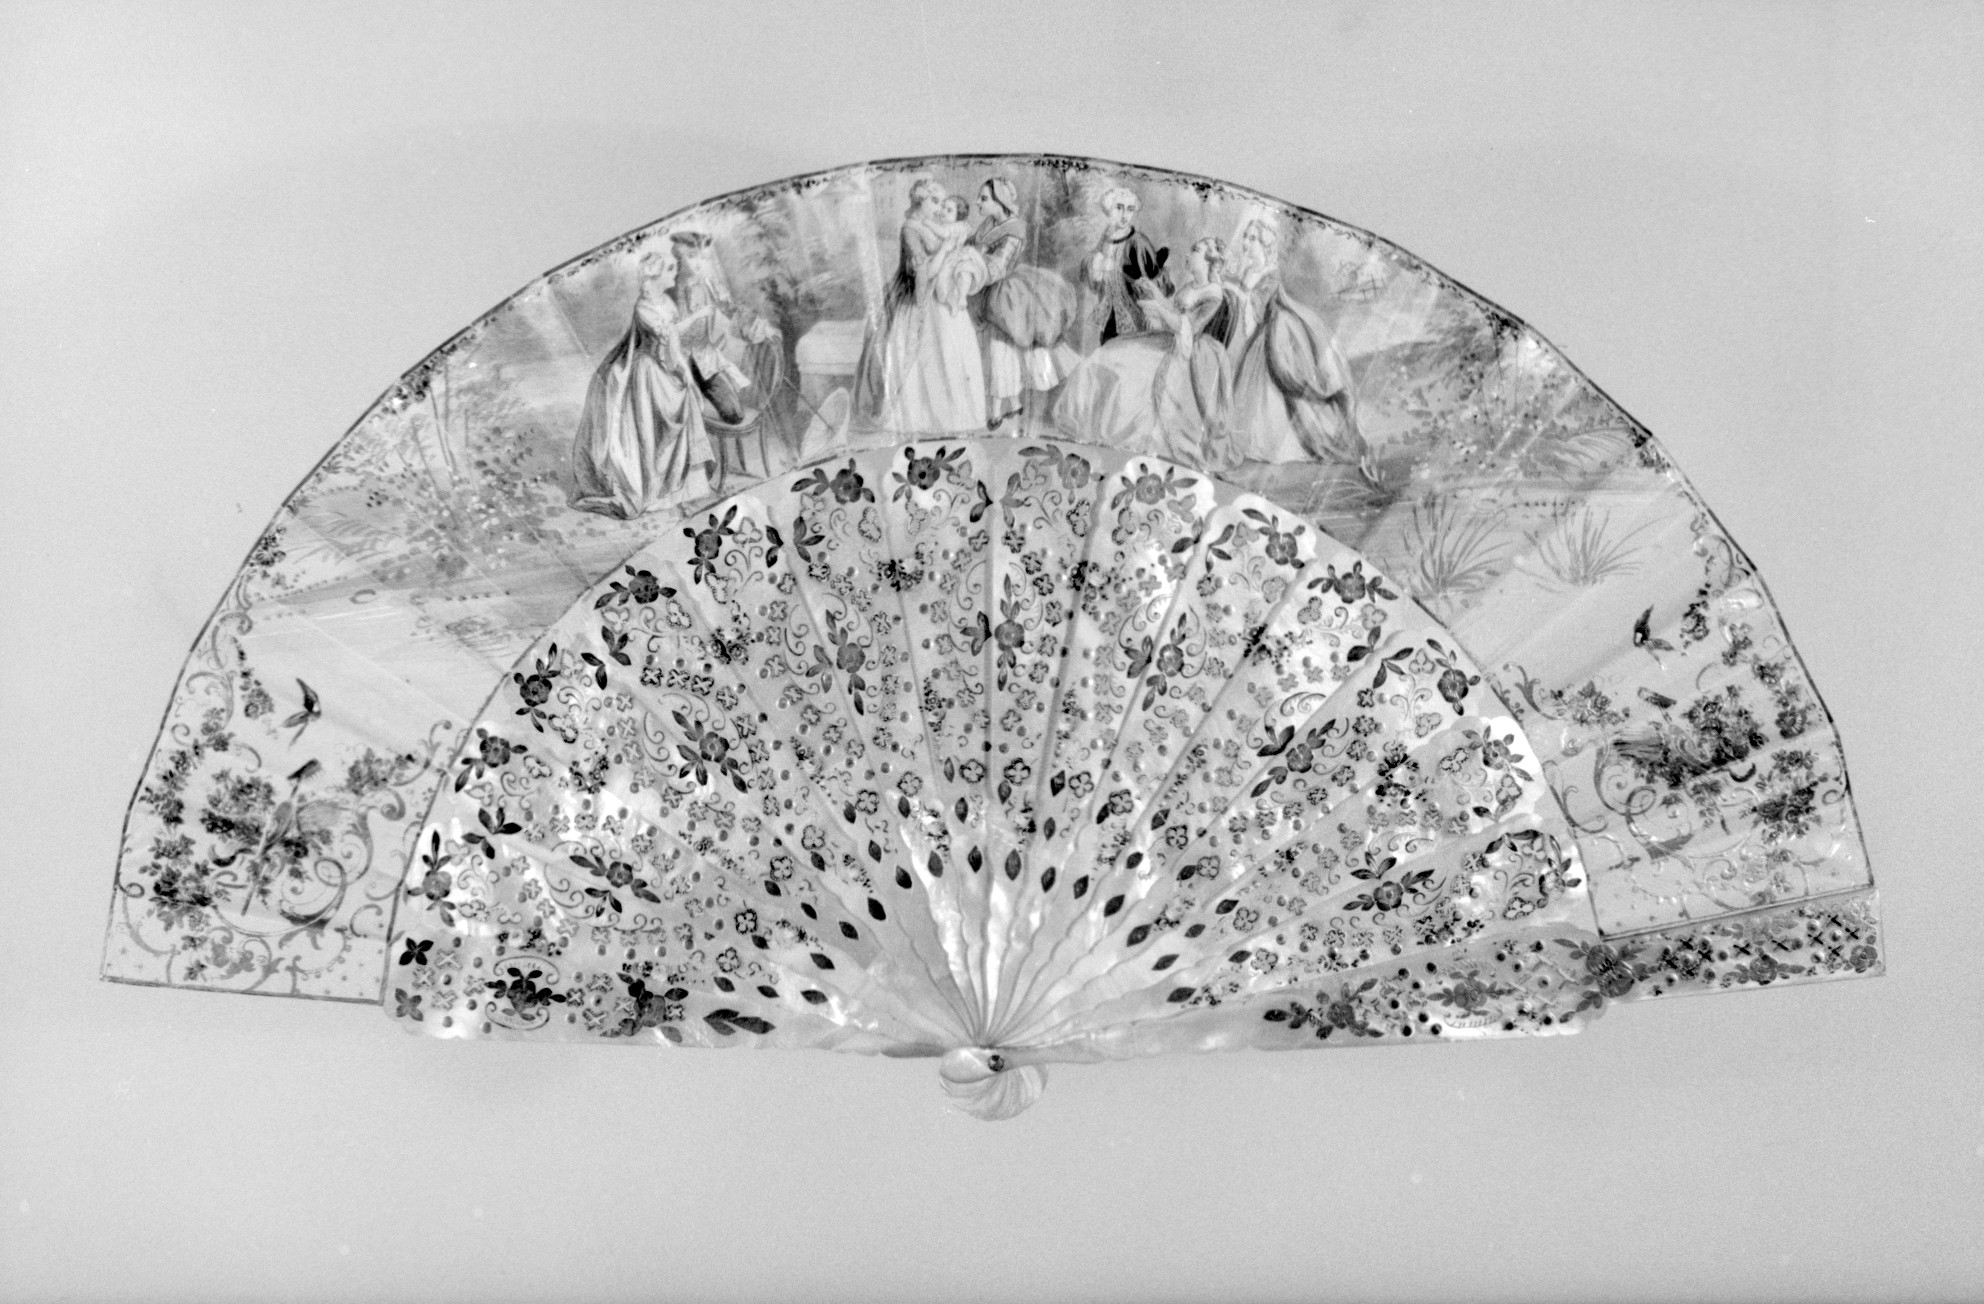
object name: fan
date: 1834-1866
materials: gilt, glass, mother of pearl, paint, paper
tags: men,women